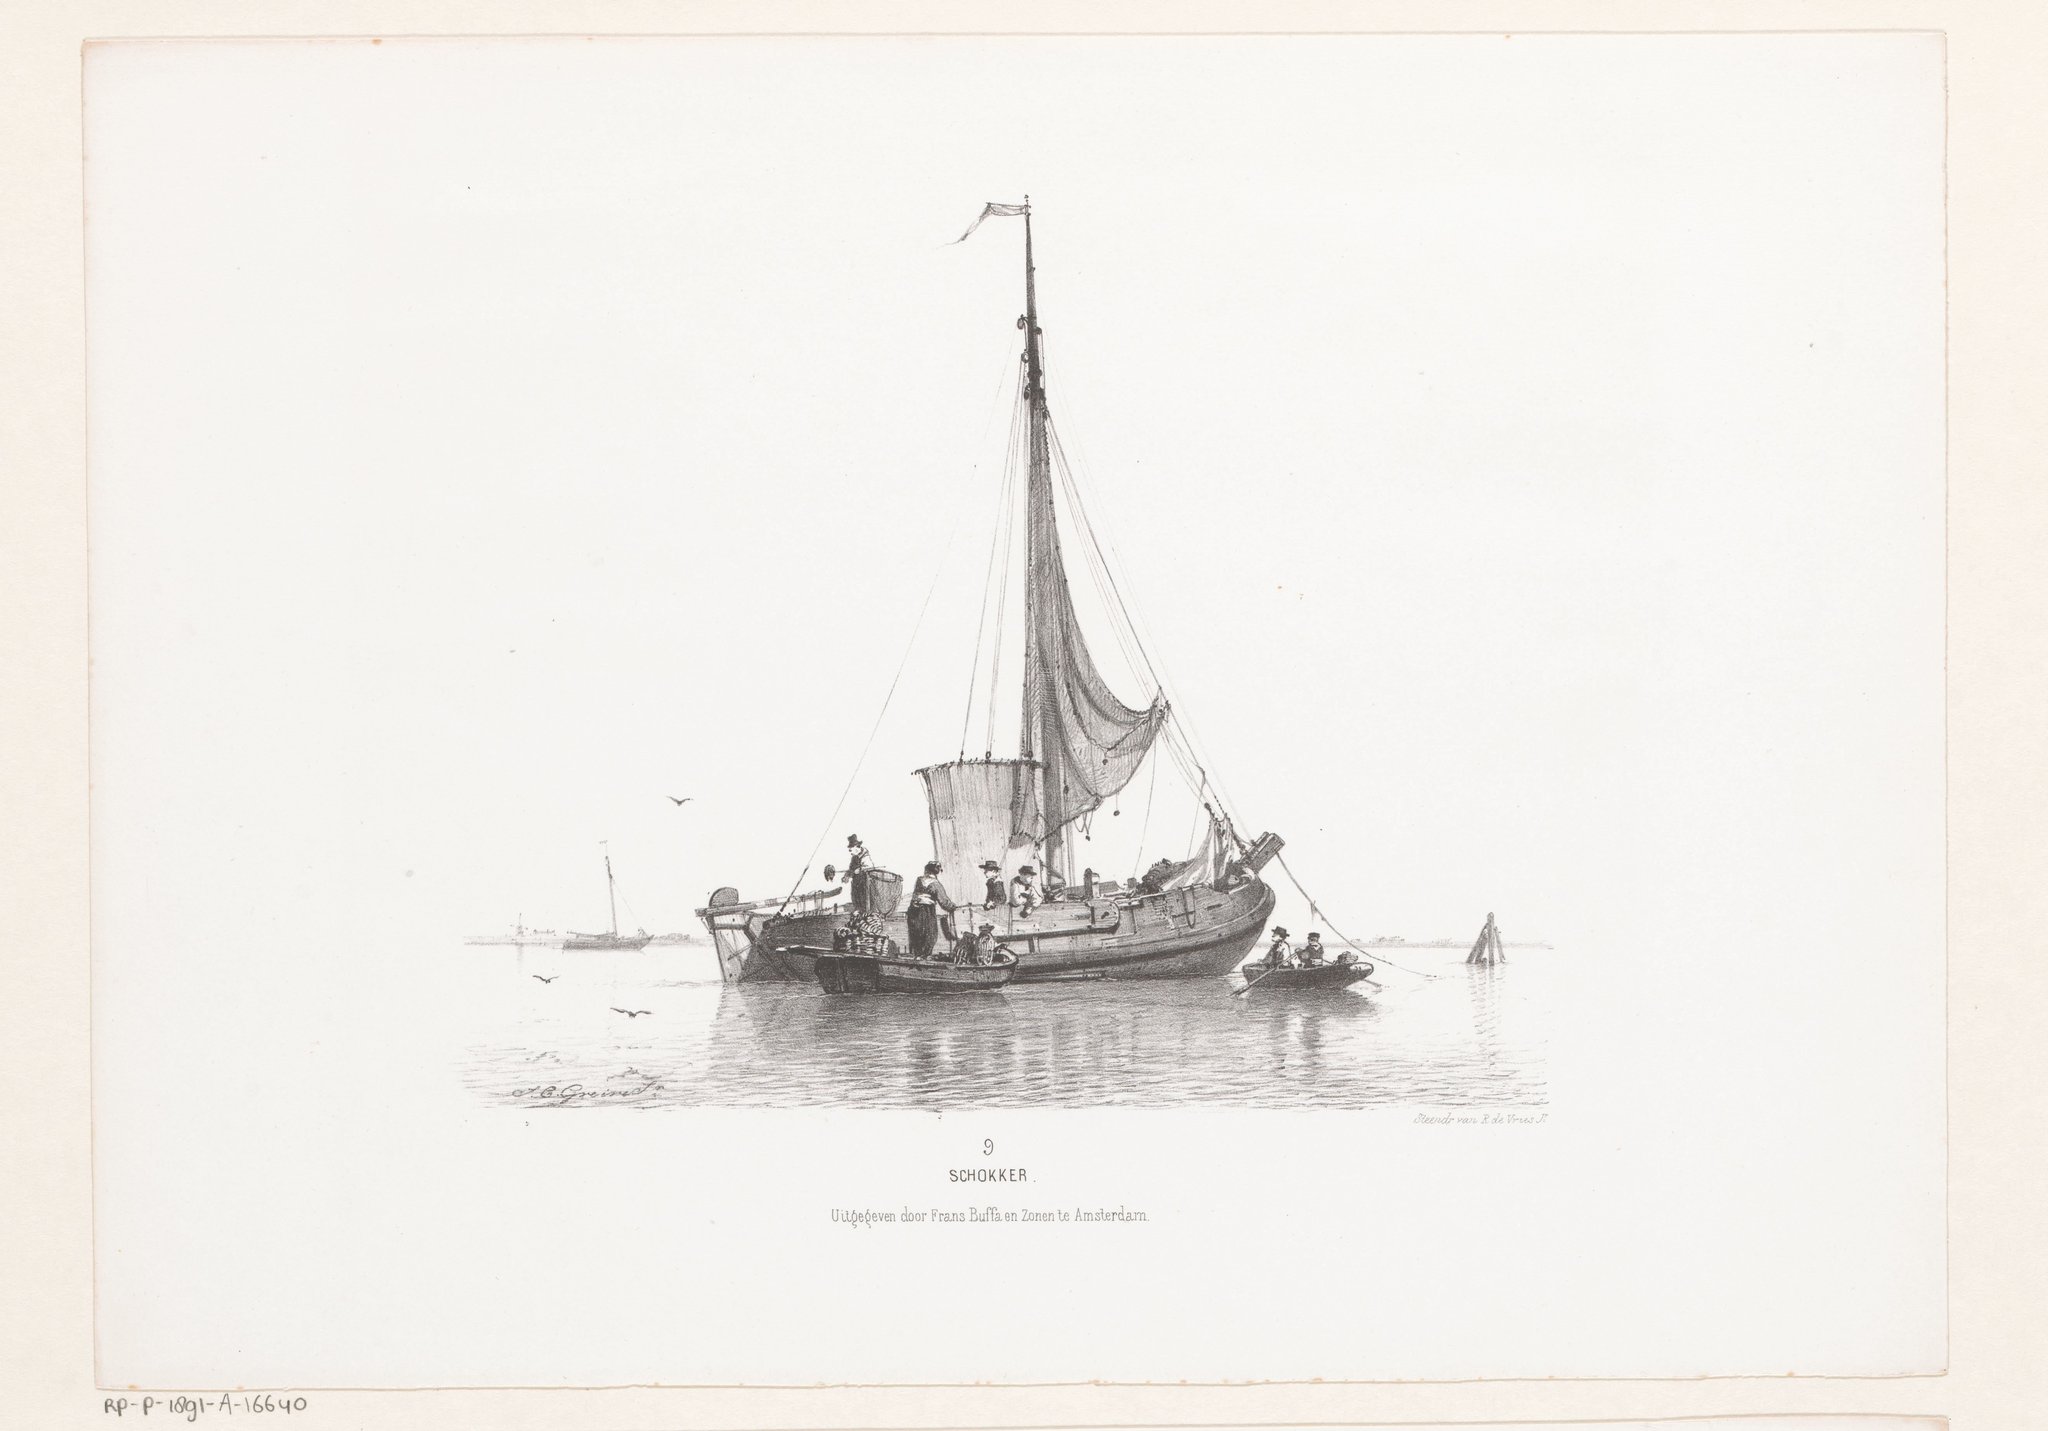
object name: print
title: Studiën van Hollandsche Schepen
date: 1860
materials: paper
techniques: lithograph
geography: netherlands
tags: sailing-ship, sailing-boat, rowing-boat, canoe, etc.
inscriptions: collector's mark: Lugt 2228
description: Figuren zijn bezig de boot te laden. Een roeiboot met fuiken komt aanvaren, een tweede vertrekt.